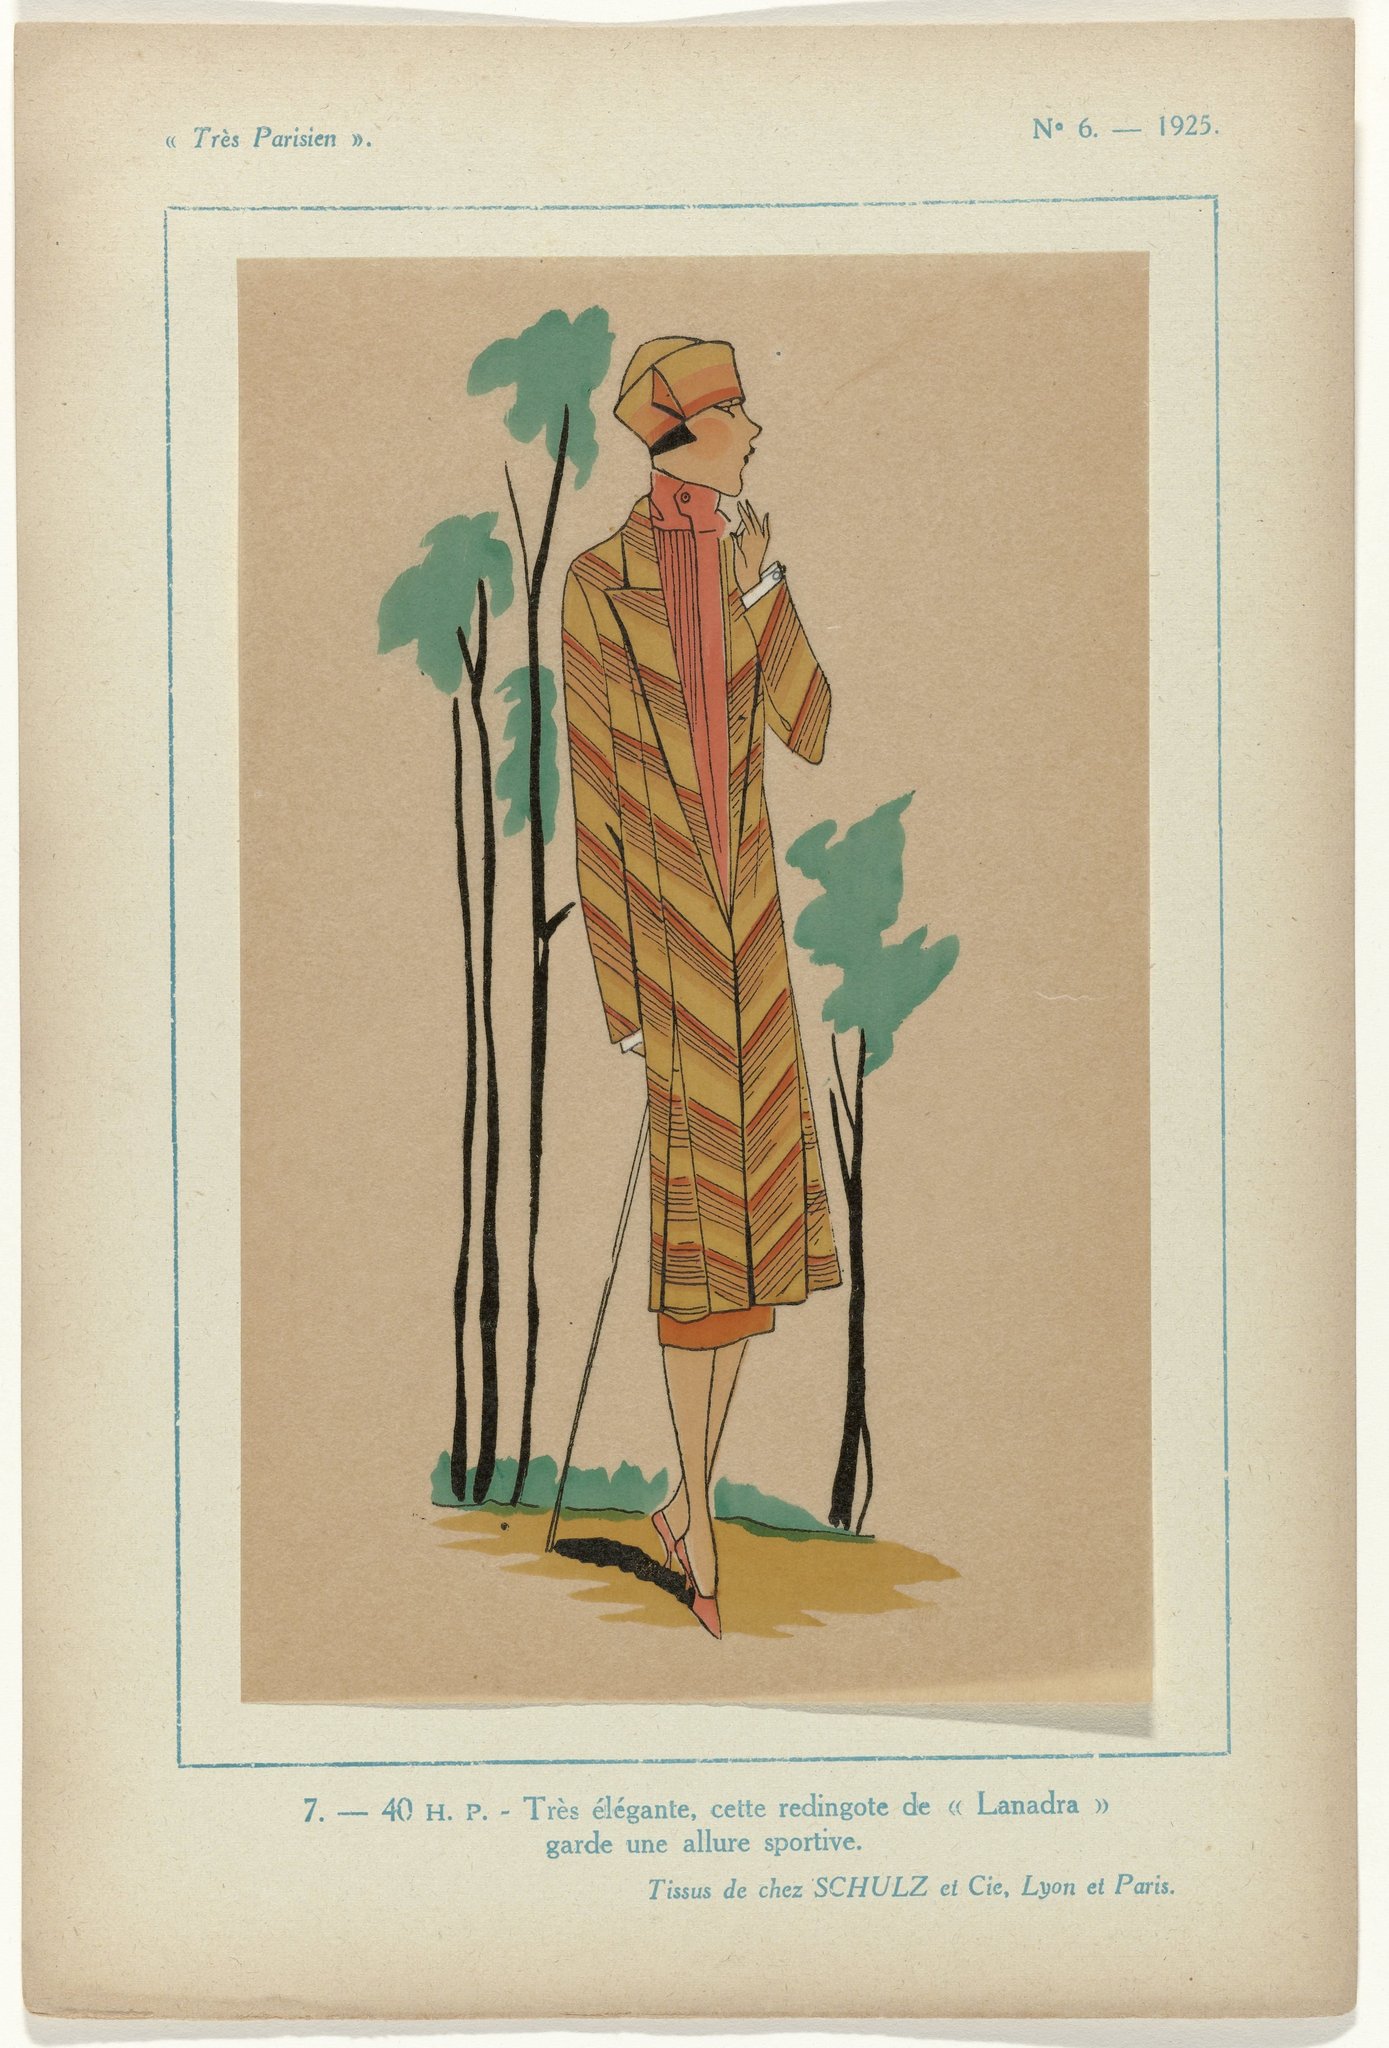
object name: fashion print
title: Très Parisien, 1925, No. 6, Pl. 7: 40 H.P. - Très élegante, cette redingot (...)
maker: g-p. joumard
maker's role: publisher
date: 1925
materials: paper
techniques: hand coloring, letterpress printing, lithography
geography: paris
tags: coat (+ women's clothes), walking-stick, staff, fashion plates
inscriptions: caption: ‘7. - 40. H.P. - Très élégante, cette redingote de "Lanadra" garde une allure sportive.’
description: Elegante redingote van 'Lanadra' als sportieve mantel. Stof van Schulz, Lyon en Parijs. Prent uit het modetijdschrift Très Parisien...La Mode, Le Chic, L'Élégance (1920-1936)